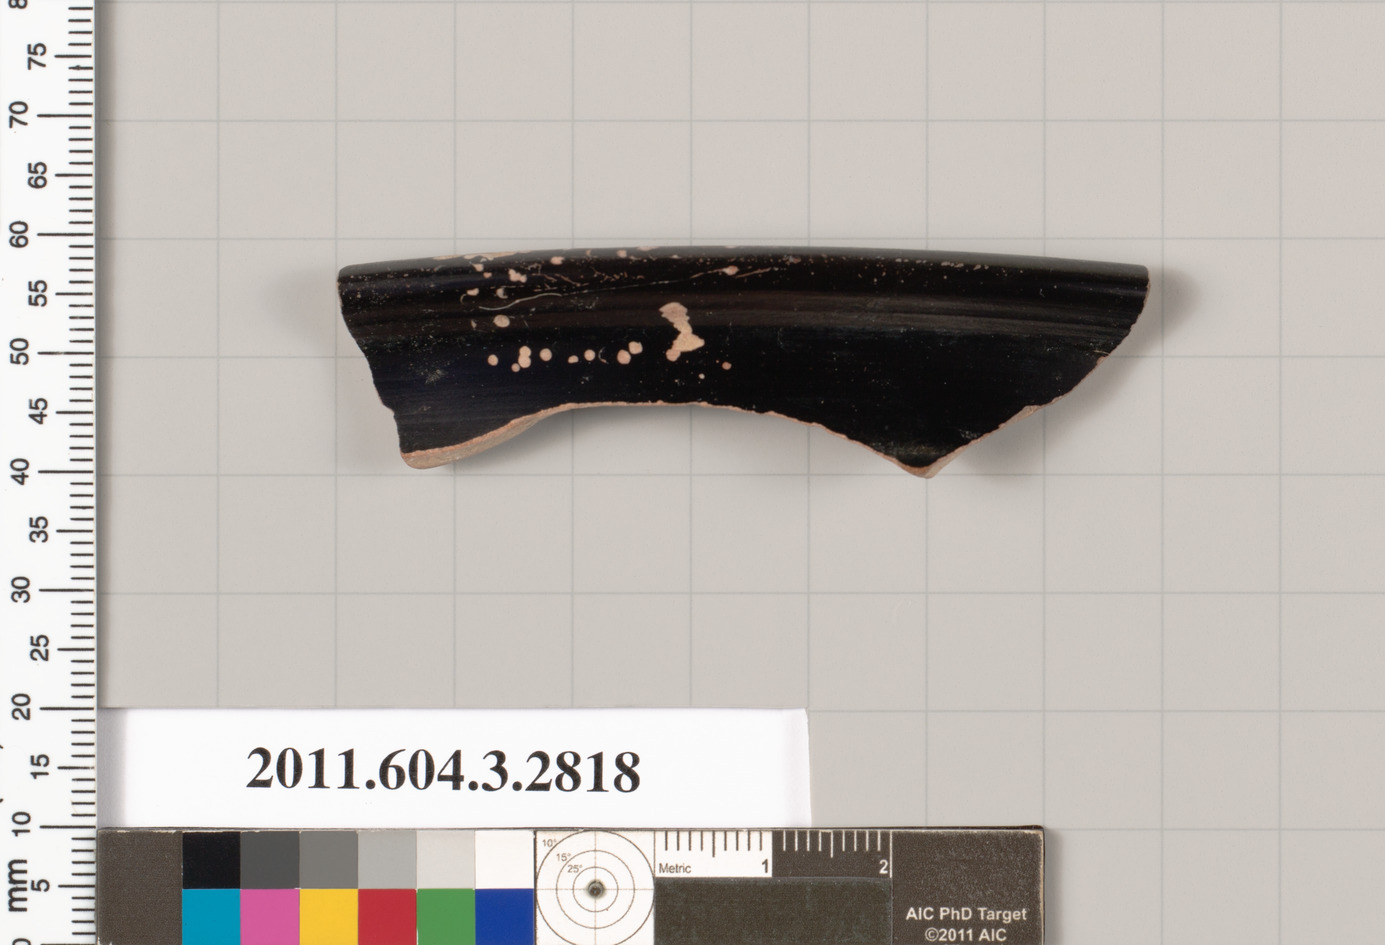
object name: oinochoe fragment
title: Terracotta fragment of an oinochoe (jug)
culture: greek, attic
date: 500-401 BCE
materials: terracotta